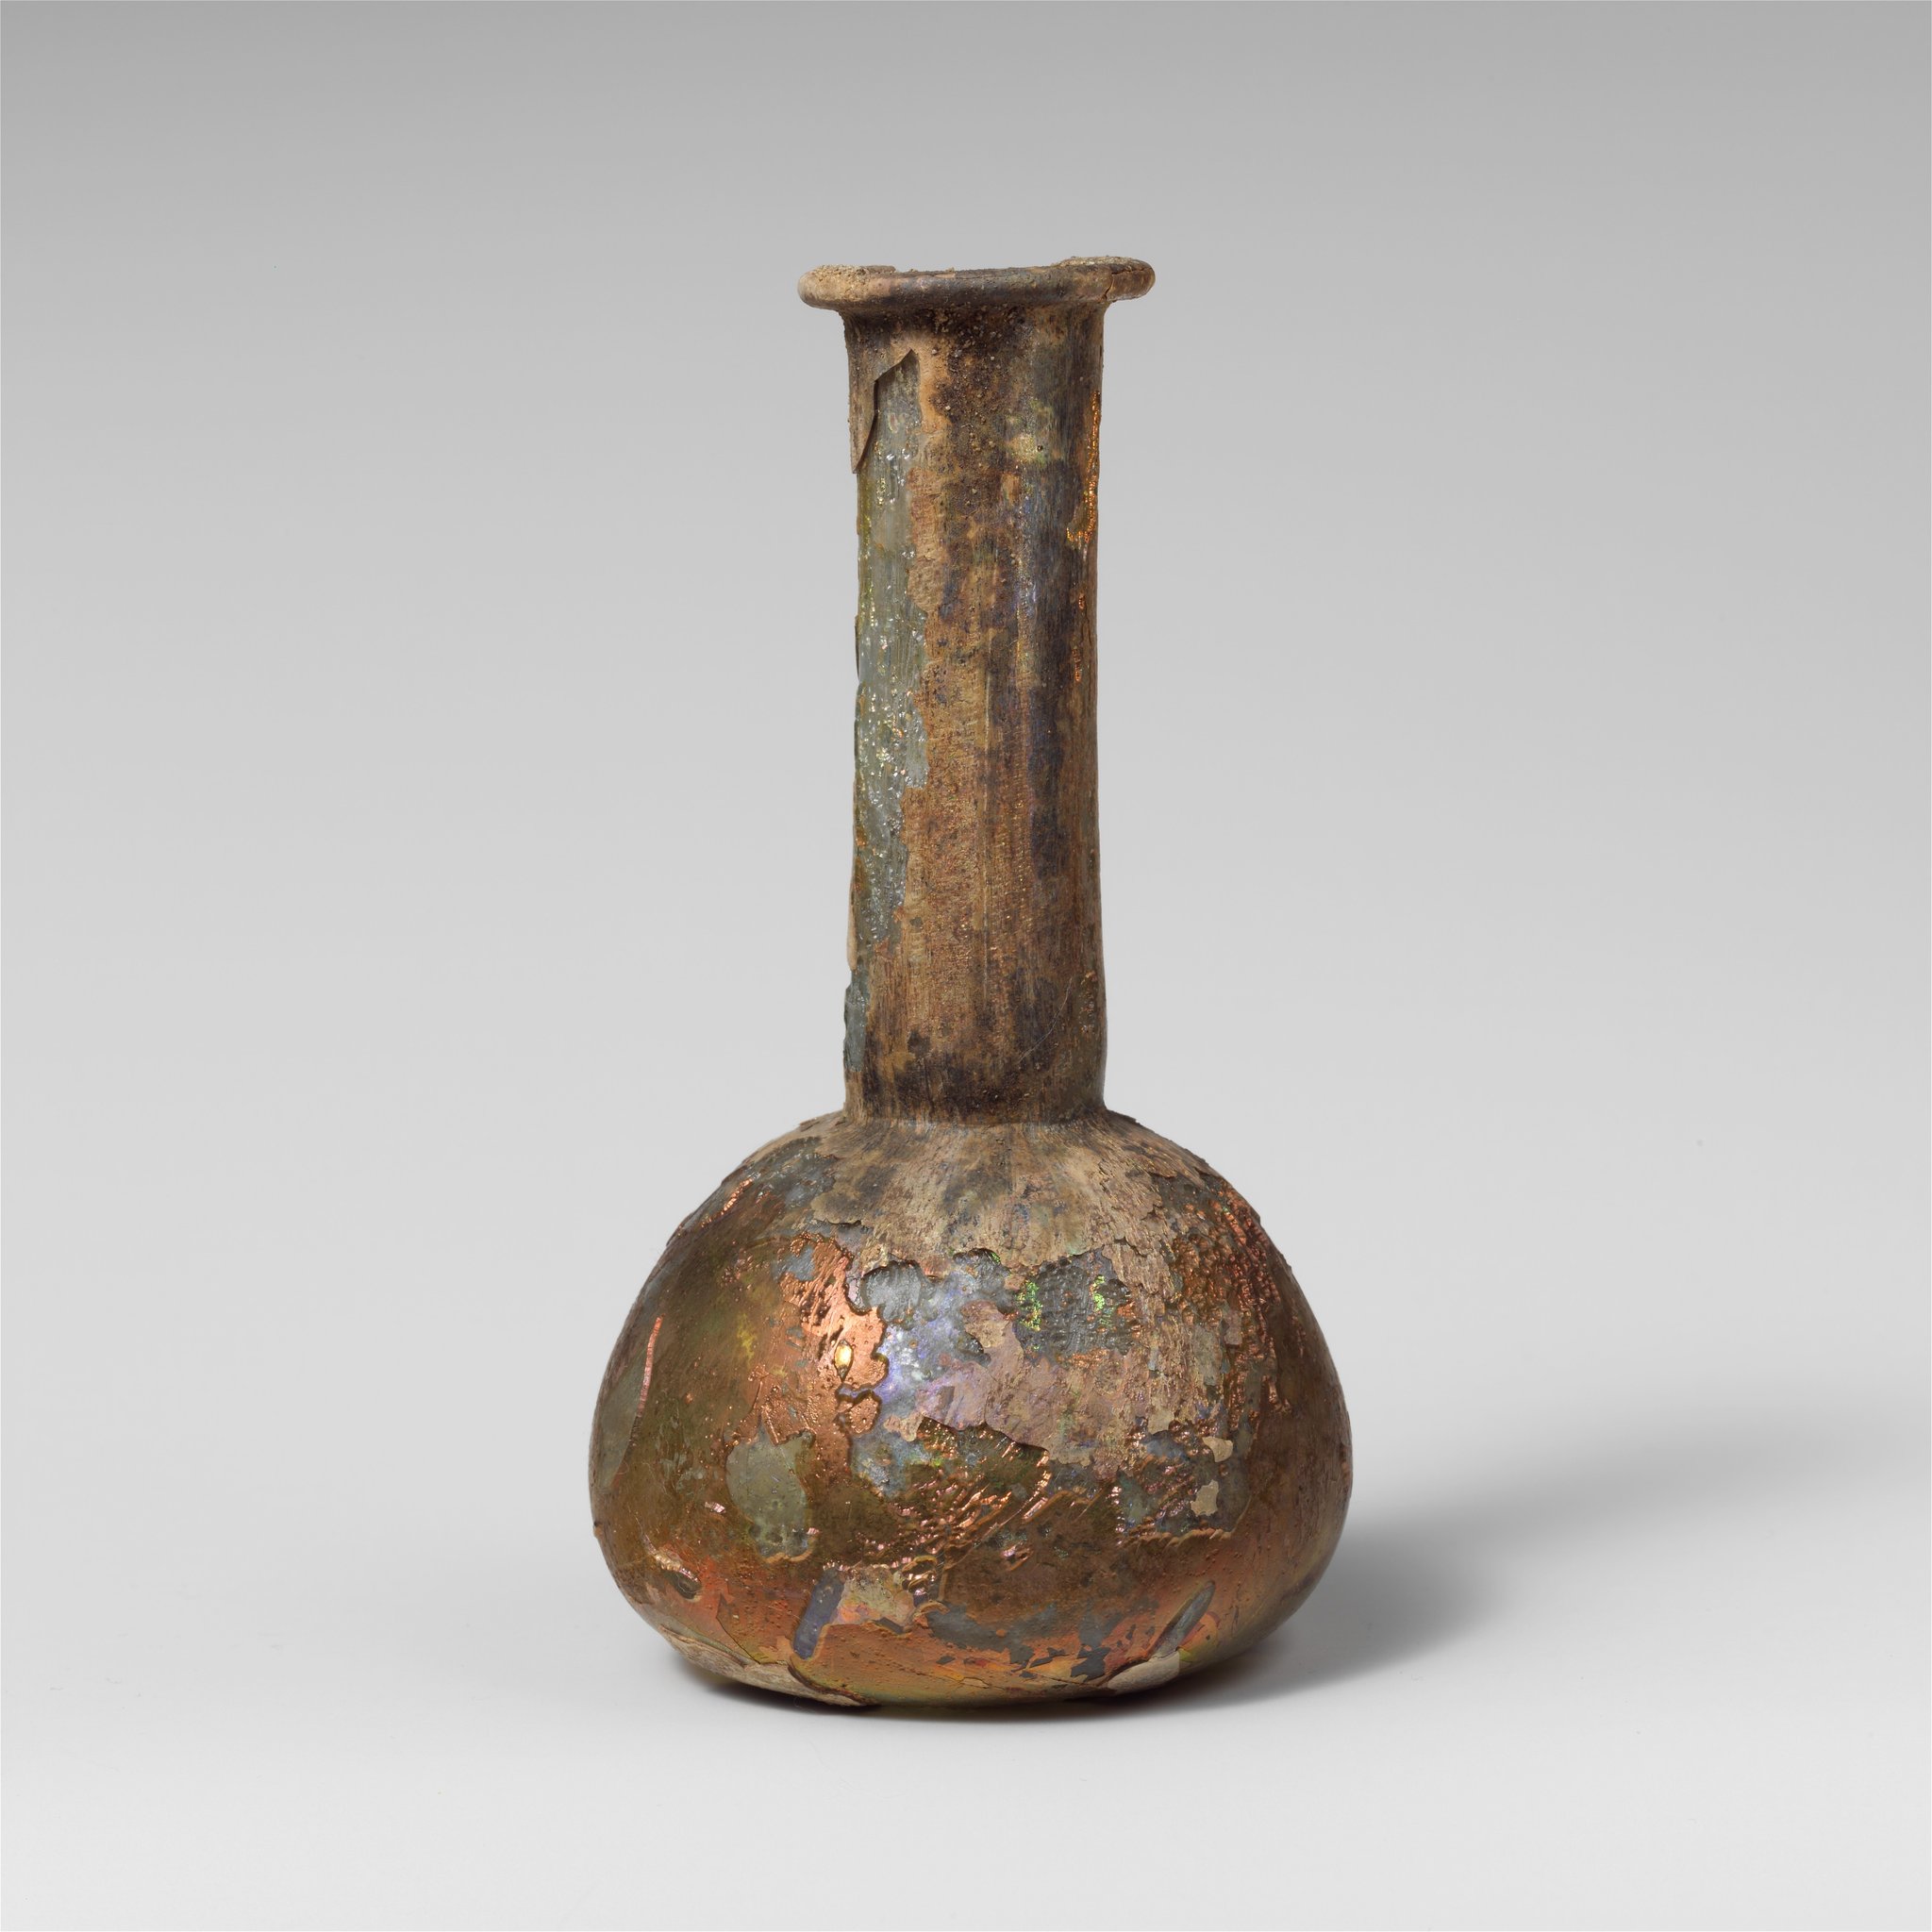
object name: perfume bottle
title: Glass perfume bottle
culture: roman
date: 101-300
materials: glass